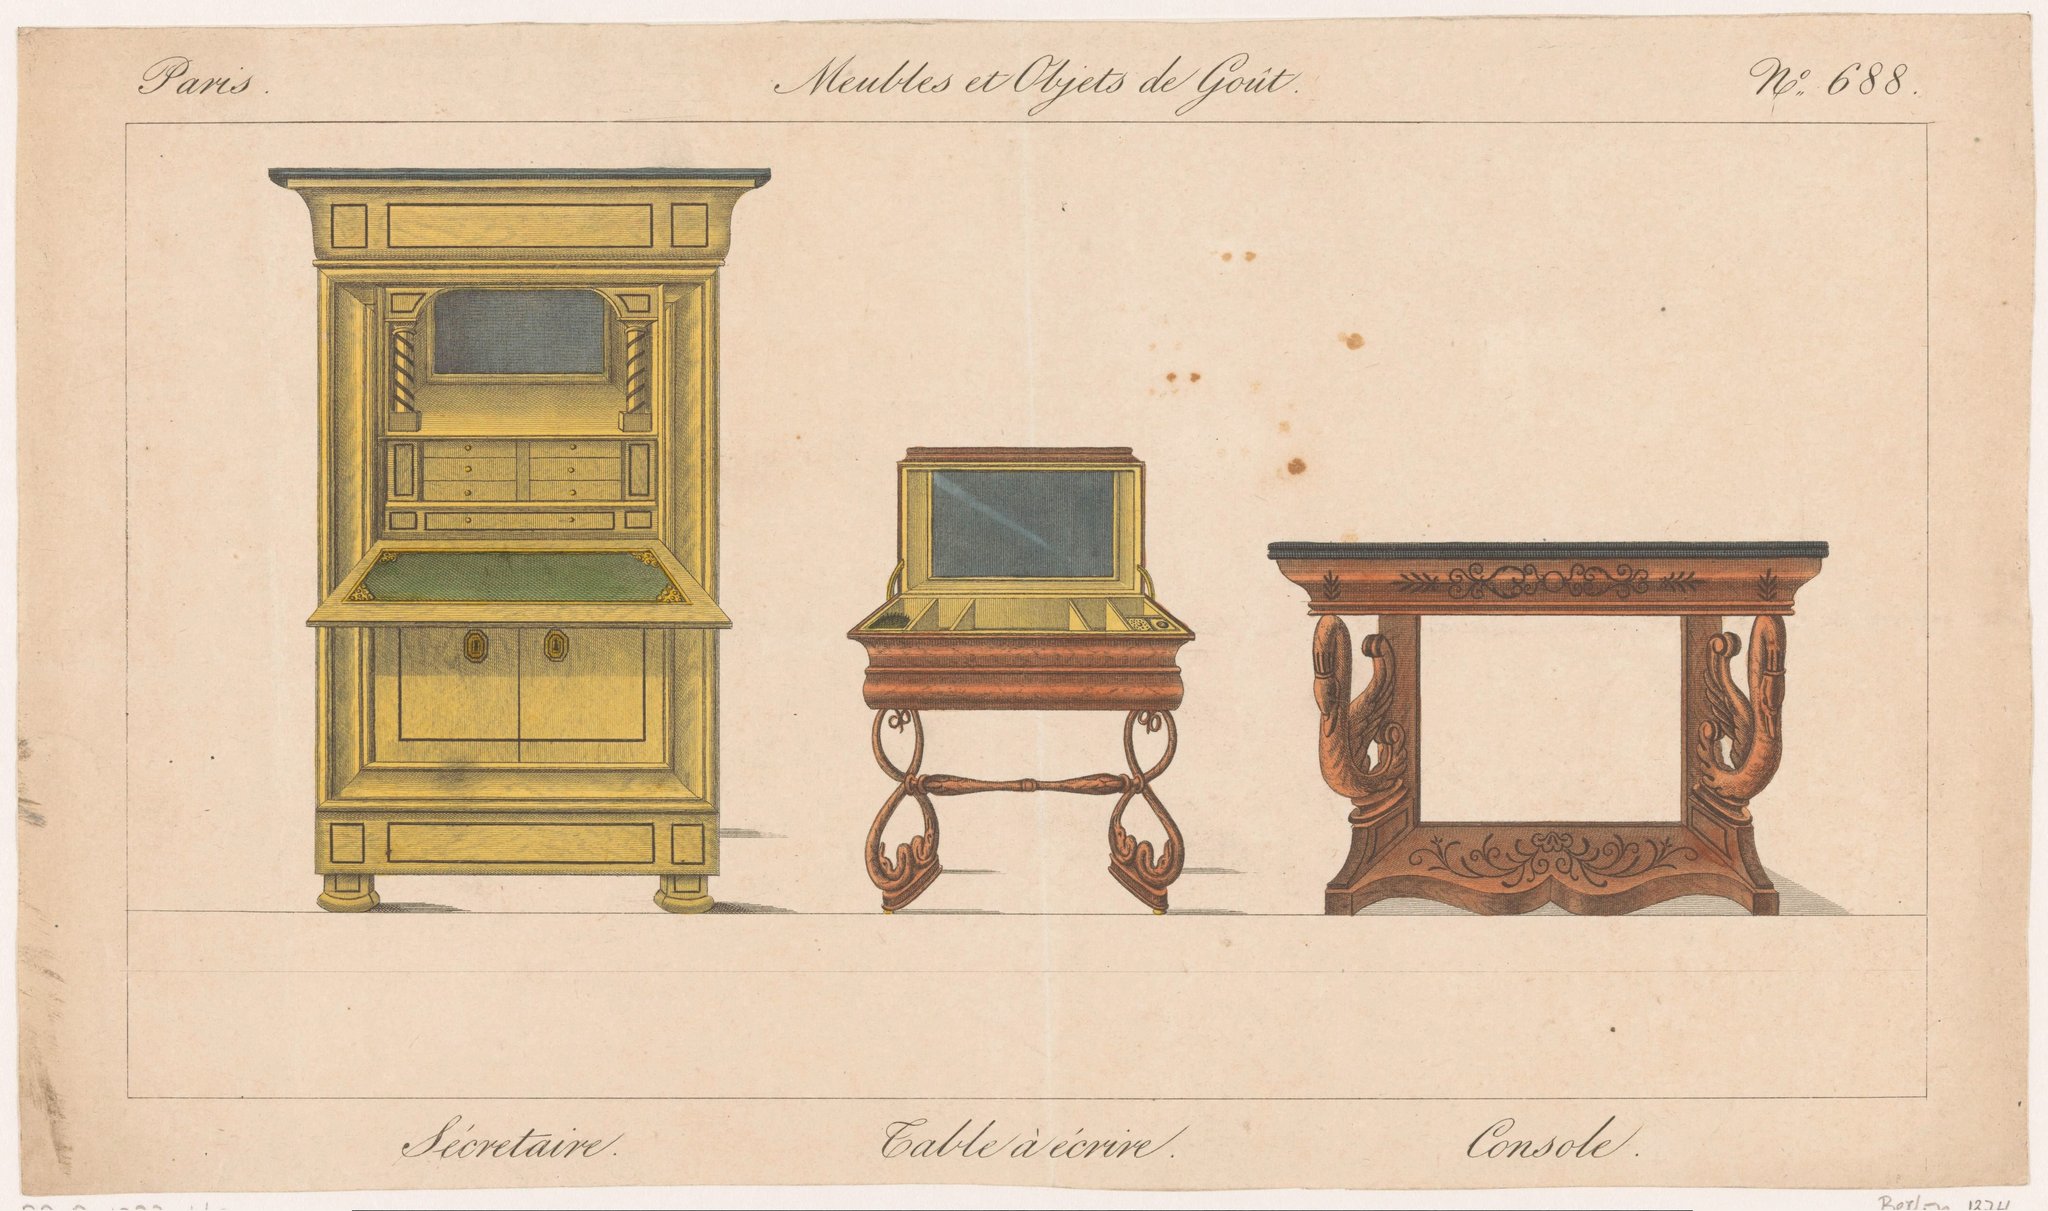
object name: print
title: Secretaire en twee tafels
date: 1801-1831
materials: paper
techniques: engraving, hand coloring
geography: paris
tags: writing-table, writing-desk, table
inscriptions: collector's mark: Lugt 2233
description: Ontwerpen voor een secretaire, een schrijftafel en een consoletafel. Prentnummer 688.